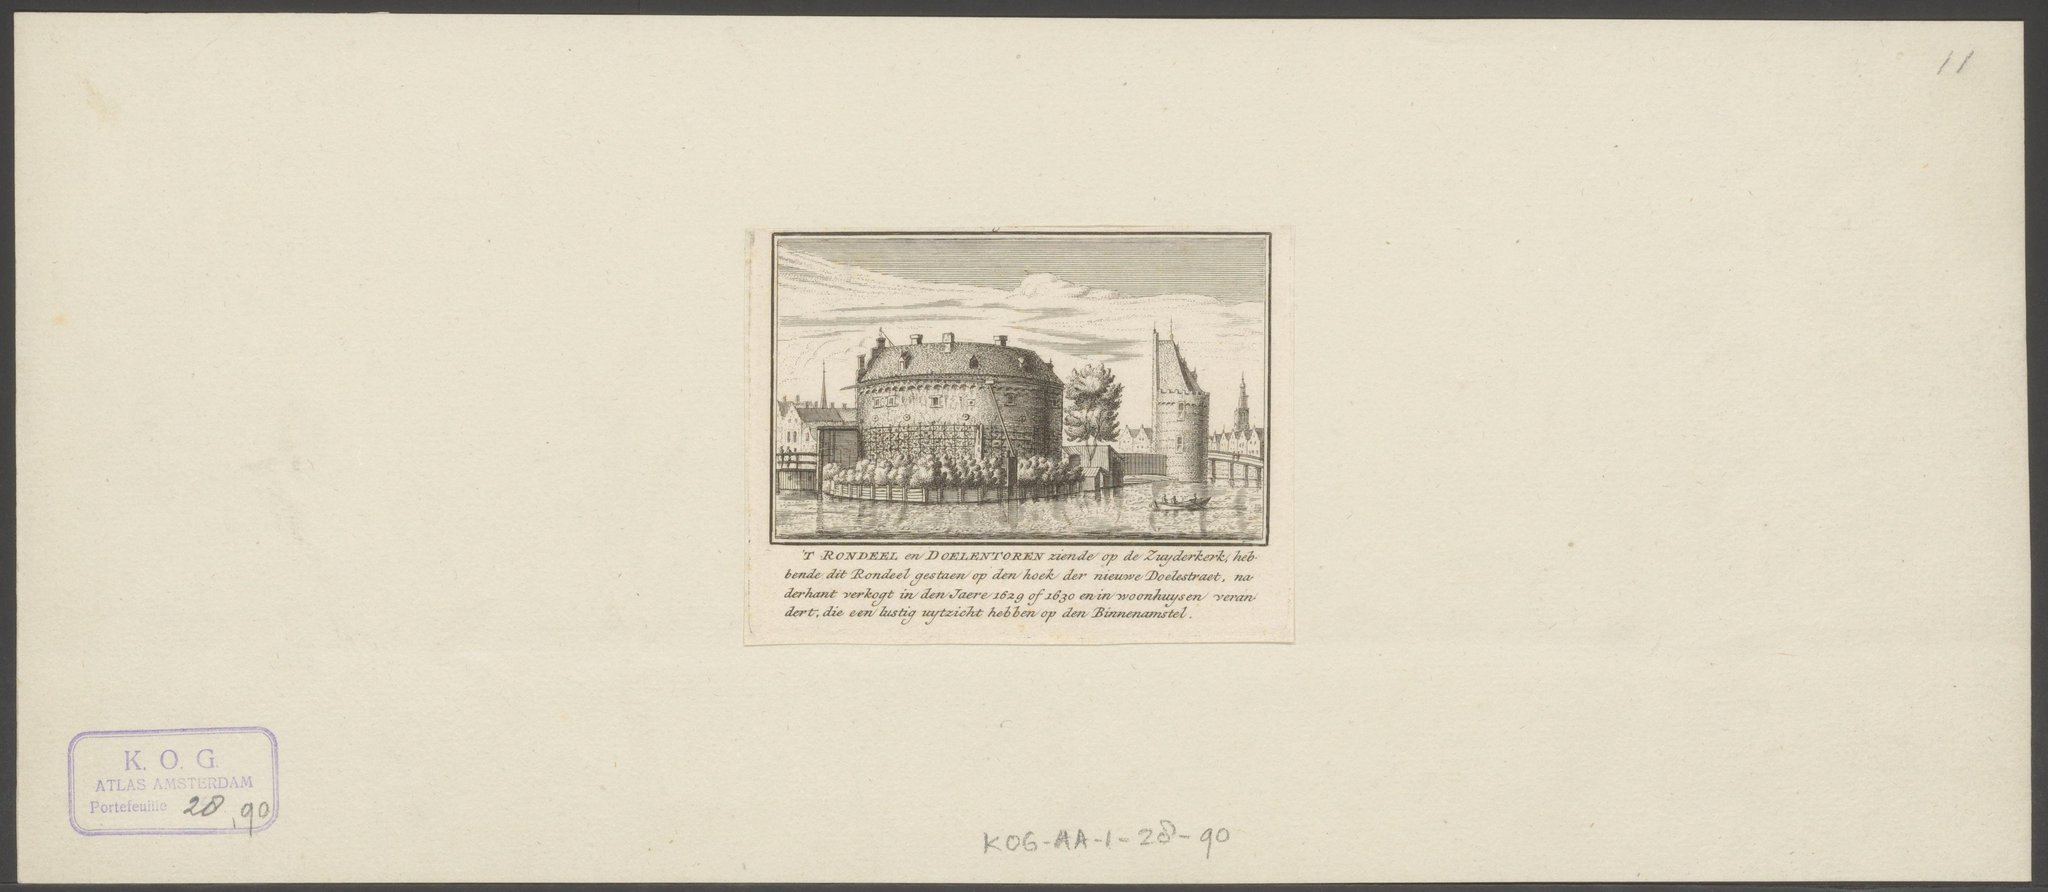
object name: print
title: Versameling van 100. Nederlantse Outheden en Gesigten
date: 1726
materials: paper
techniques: engraving, etching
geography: amsterdam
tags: towers ~ fortified city, rowing-boat, canoe, etc.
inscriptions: collector's mark: Lugt 1641b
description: Onderwerpsrubriek binnen de Atlas Amsterdam: Vestingwerken: Bolwerken - Rondeel - Wachttorens - Blokhuizen - Kazematten - Ontwerpen Kostuum Alva.